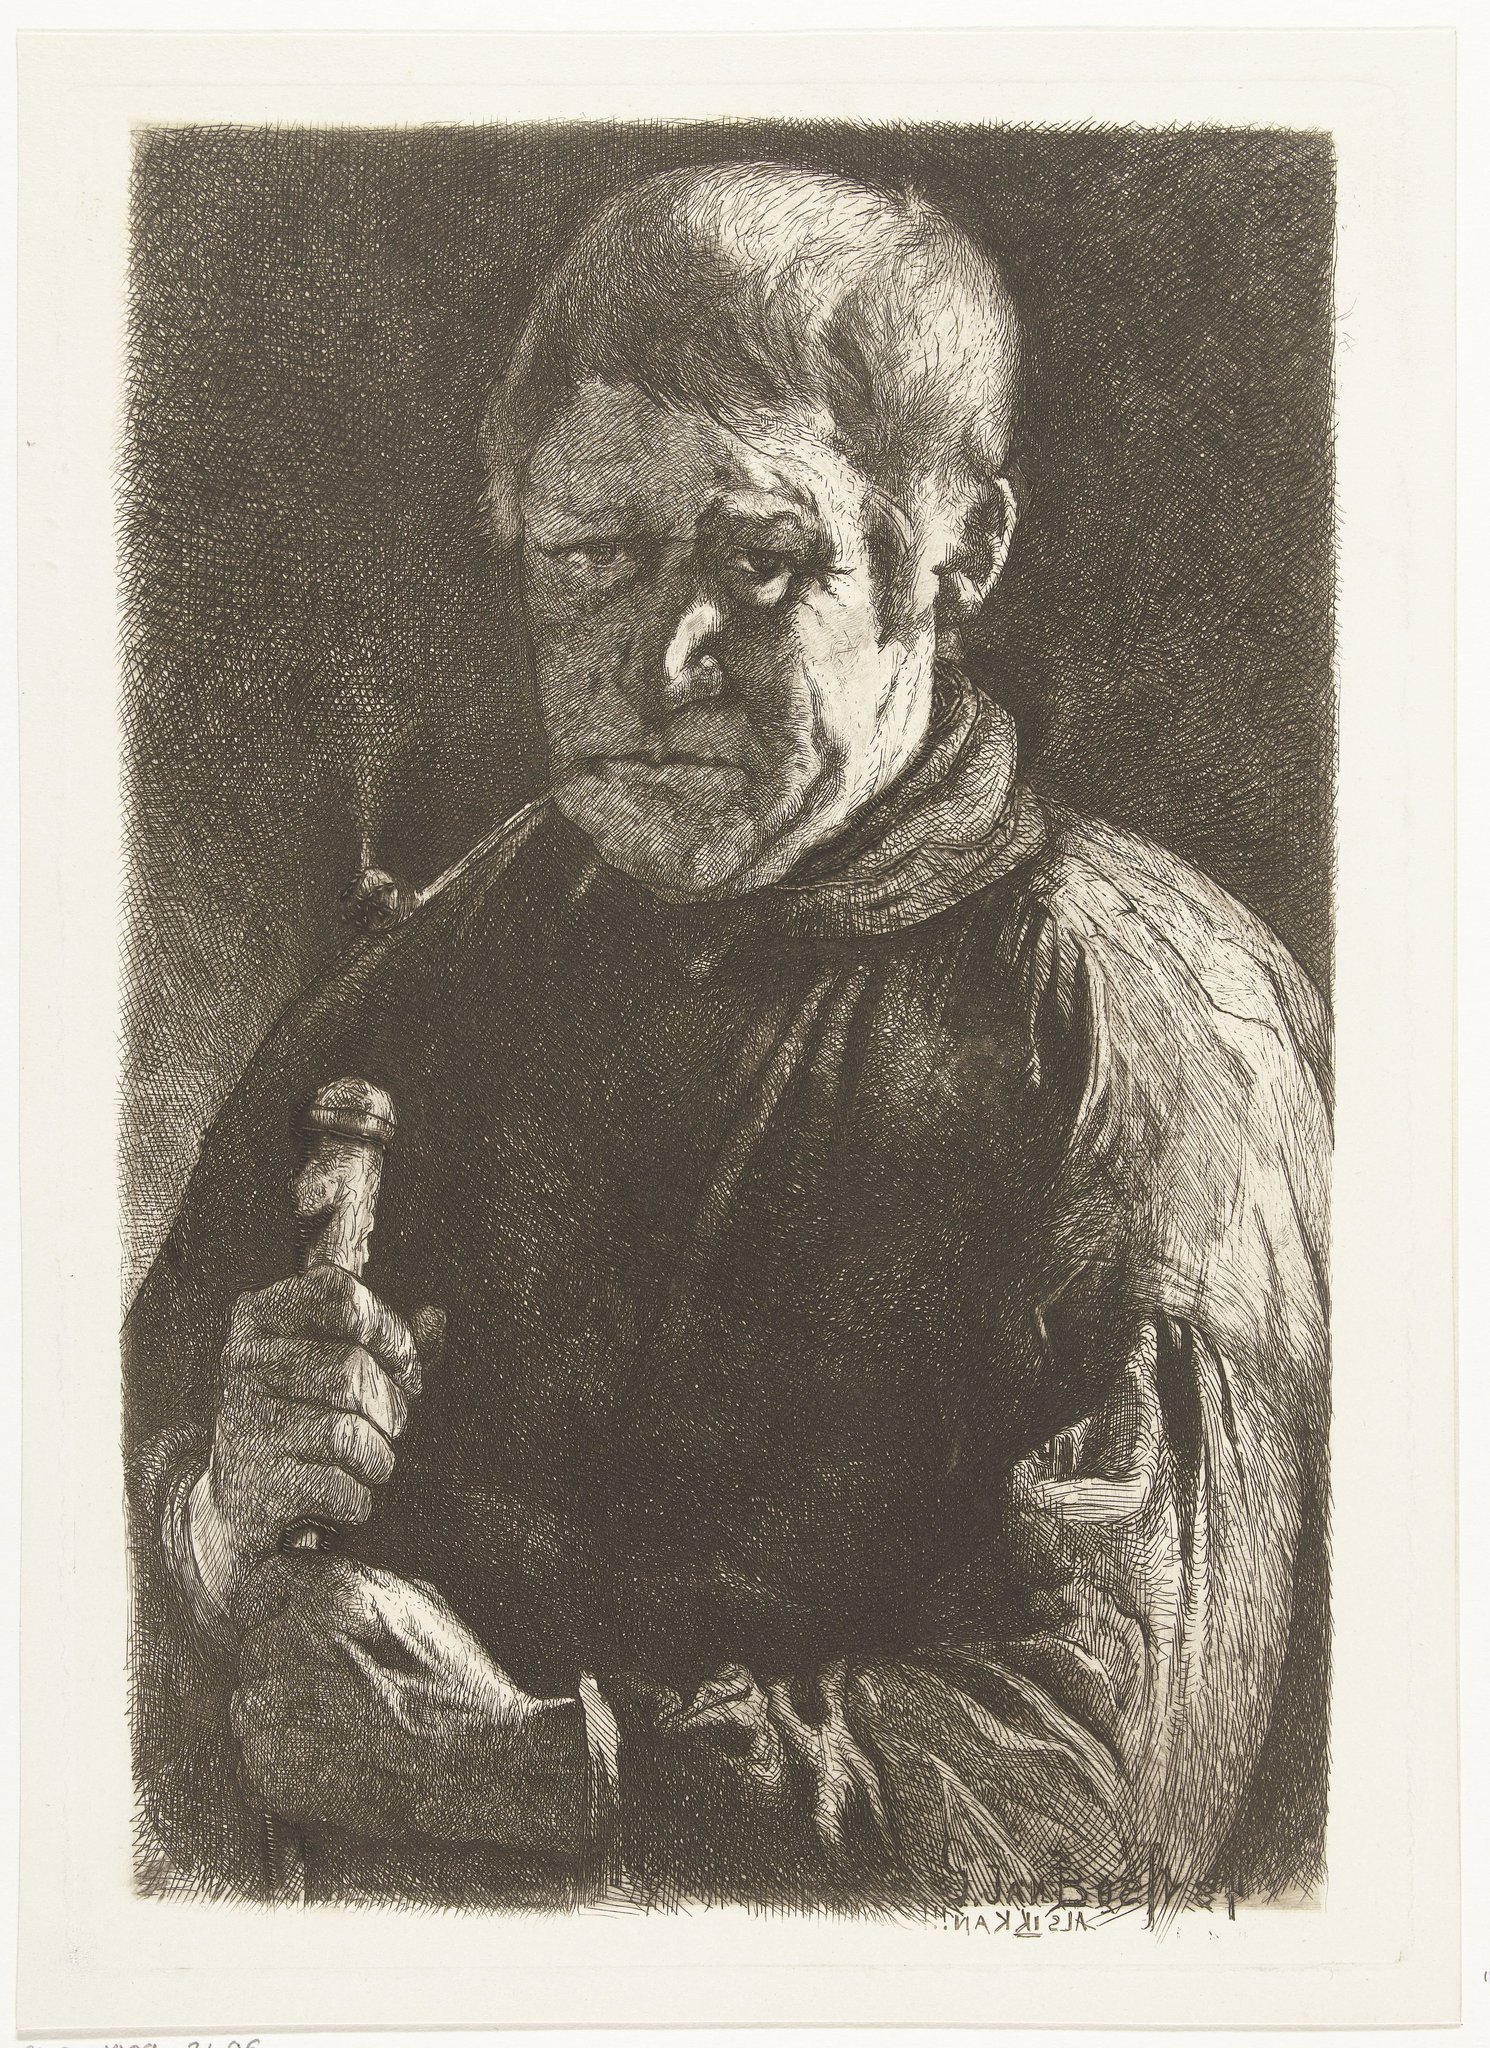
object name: print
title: Man met pijp en wandelstok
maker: gerard jan bos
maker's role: print maker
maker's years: 1860-1943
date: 1884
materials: paper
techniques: drypoint, etching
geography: antwerp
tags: pipe ~ tobacco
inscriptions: collector's mark: Lugt 2228